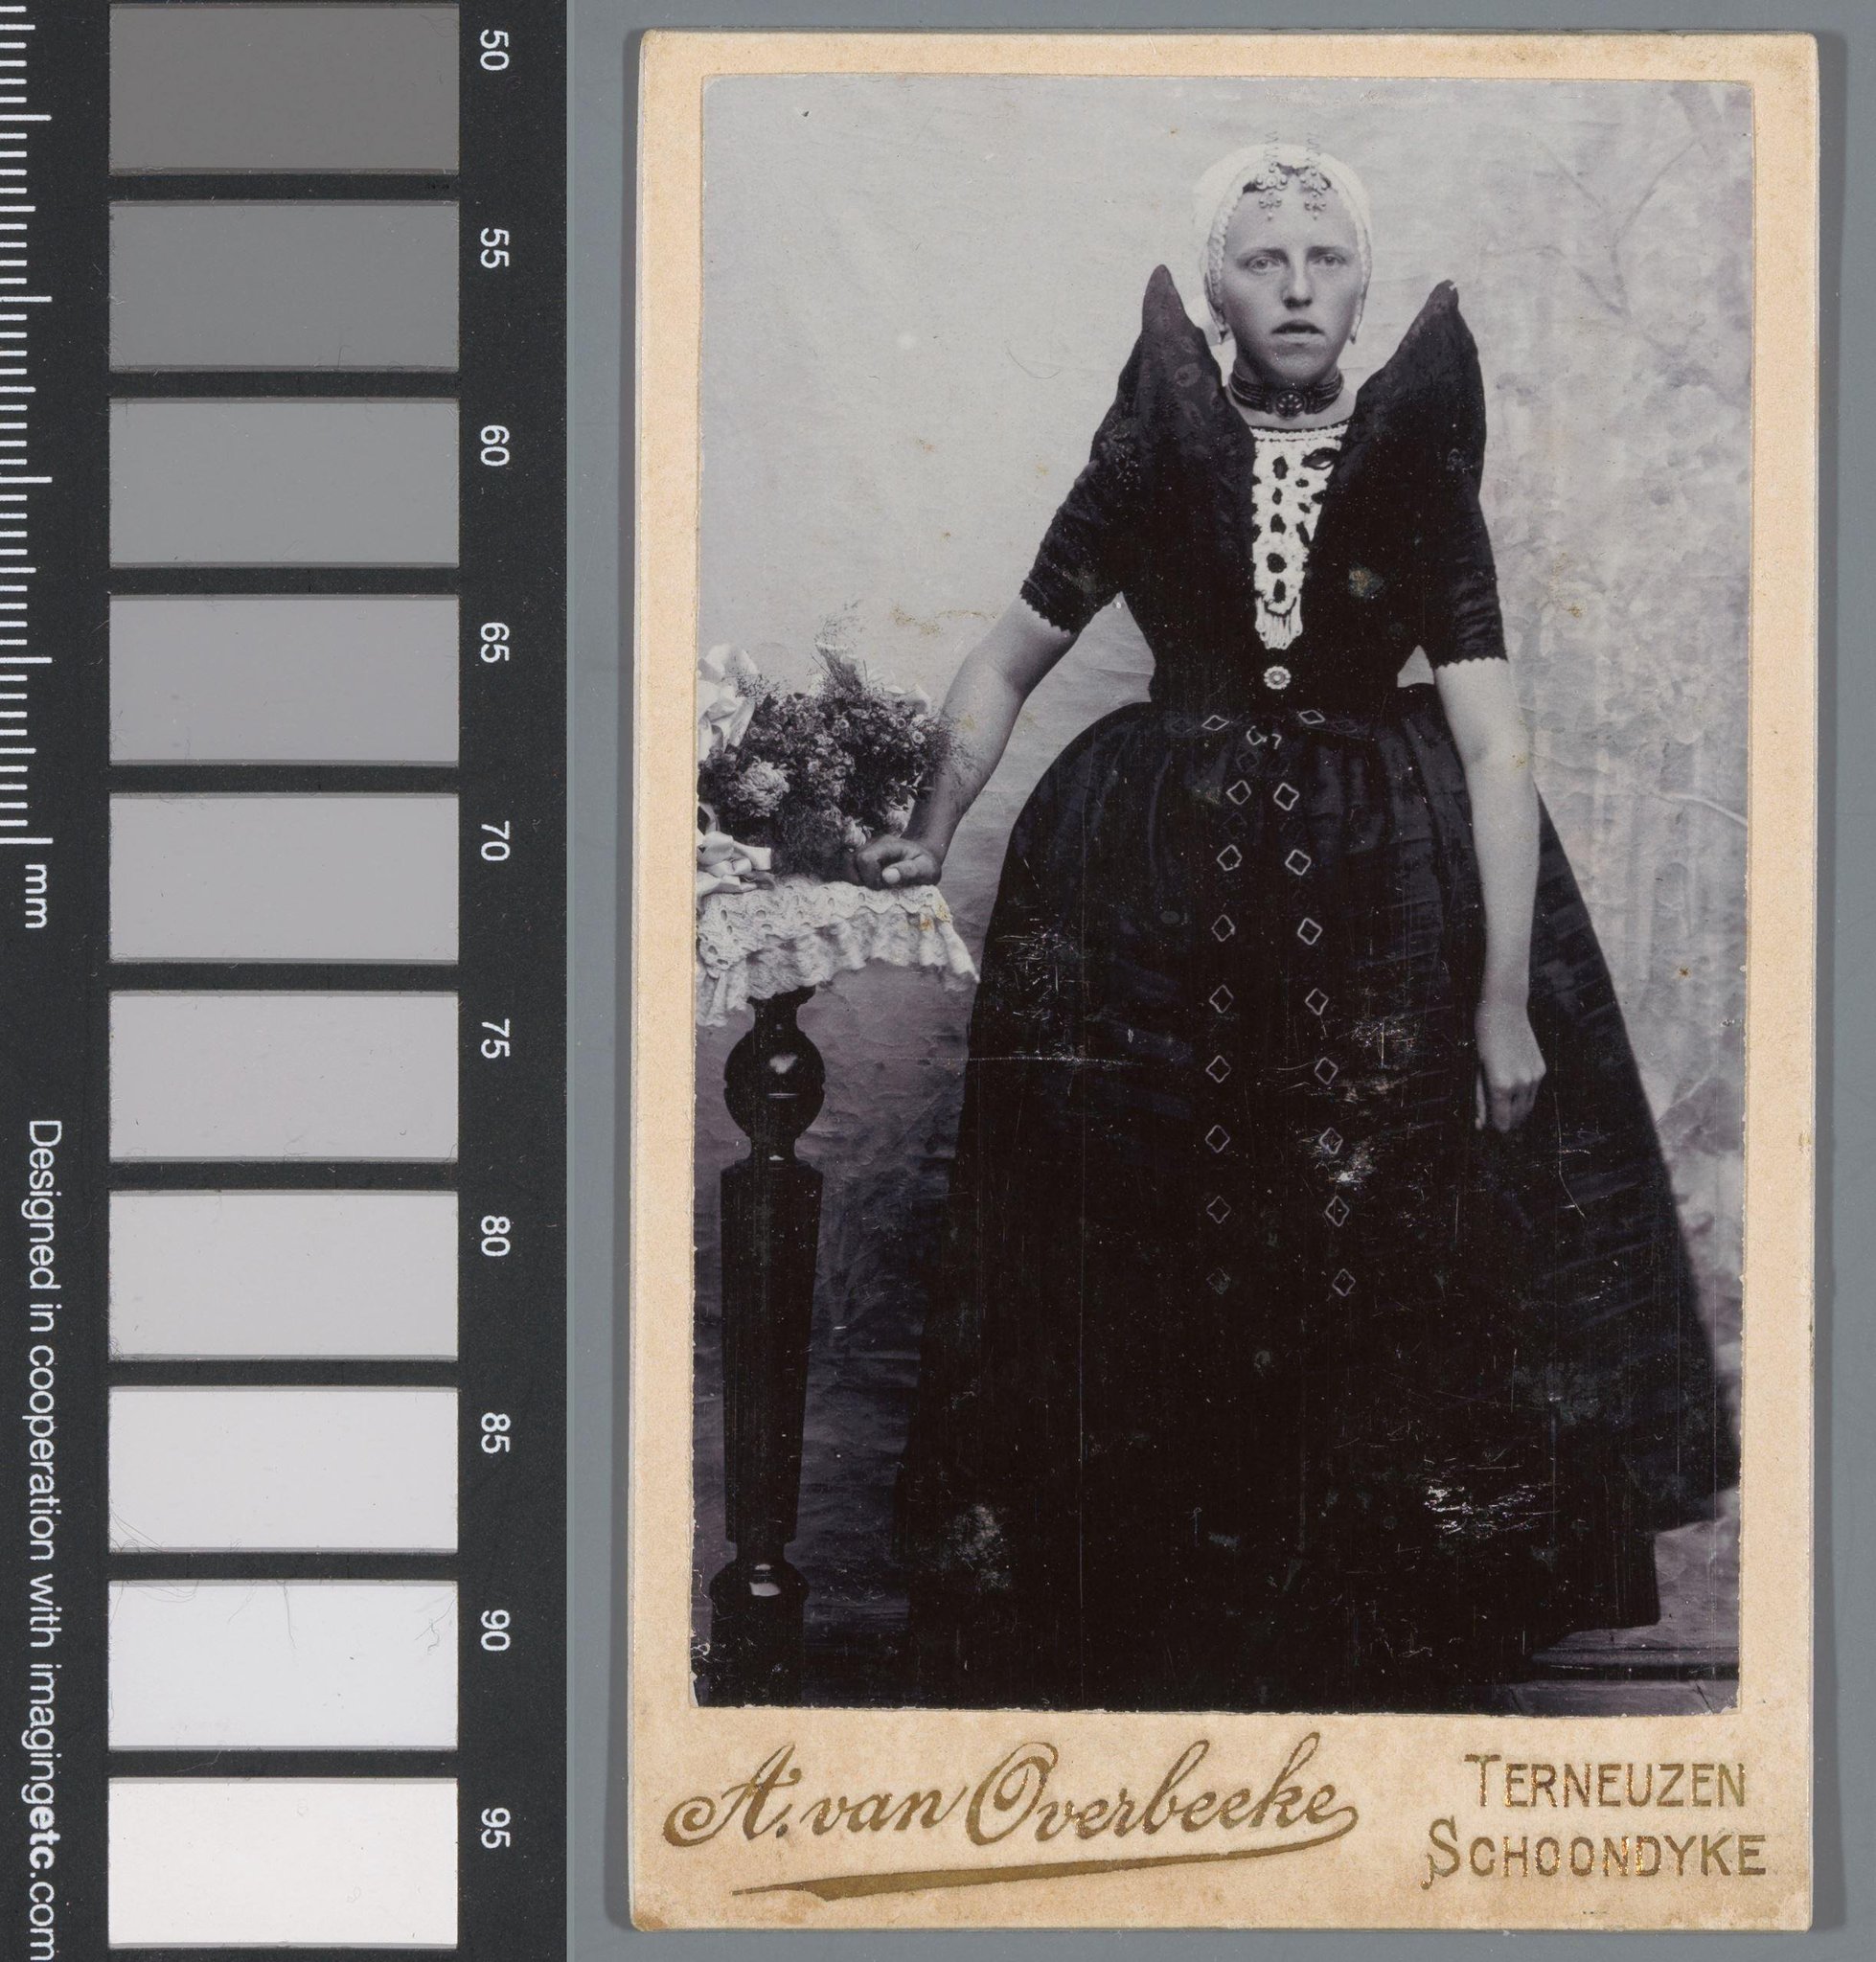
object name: photograph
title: Portret van een onbekend meisje in Zeeuwse klederdracht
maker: abraham van overbeeke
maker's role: publisher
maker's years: 1836-1914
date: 1890-1914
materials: paper, cardboard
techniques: collodion silver print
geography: terneuzen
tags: adolescent, young woman, maiden, anonymous historical person portrayed, folk costume, regional costume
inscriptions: address: ‘SCHOONDYKE/ Markt./ TERNEUZEN/ Donze-Visserstraat.’, inscription: ‘Deplaat blyft voor nabestelling bewaard./ Vergrootingen naar ieder beeld.’